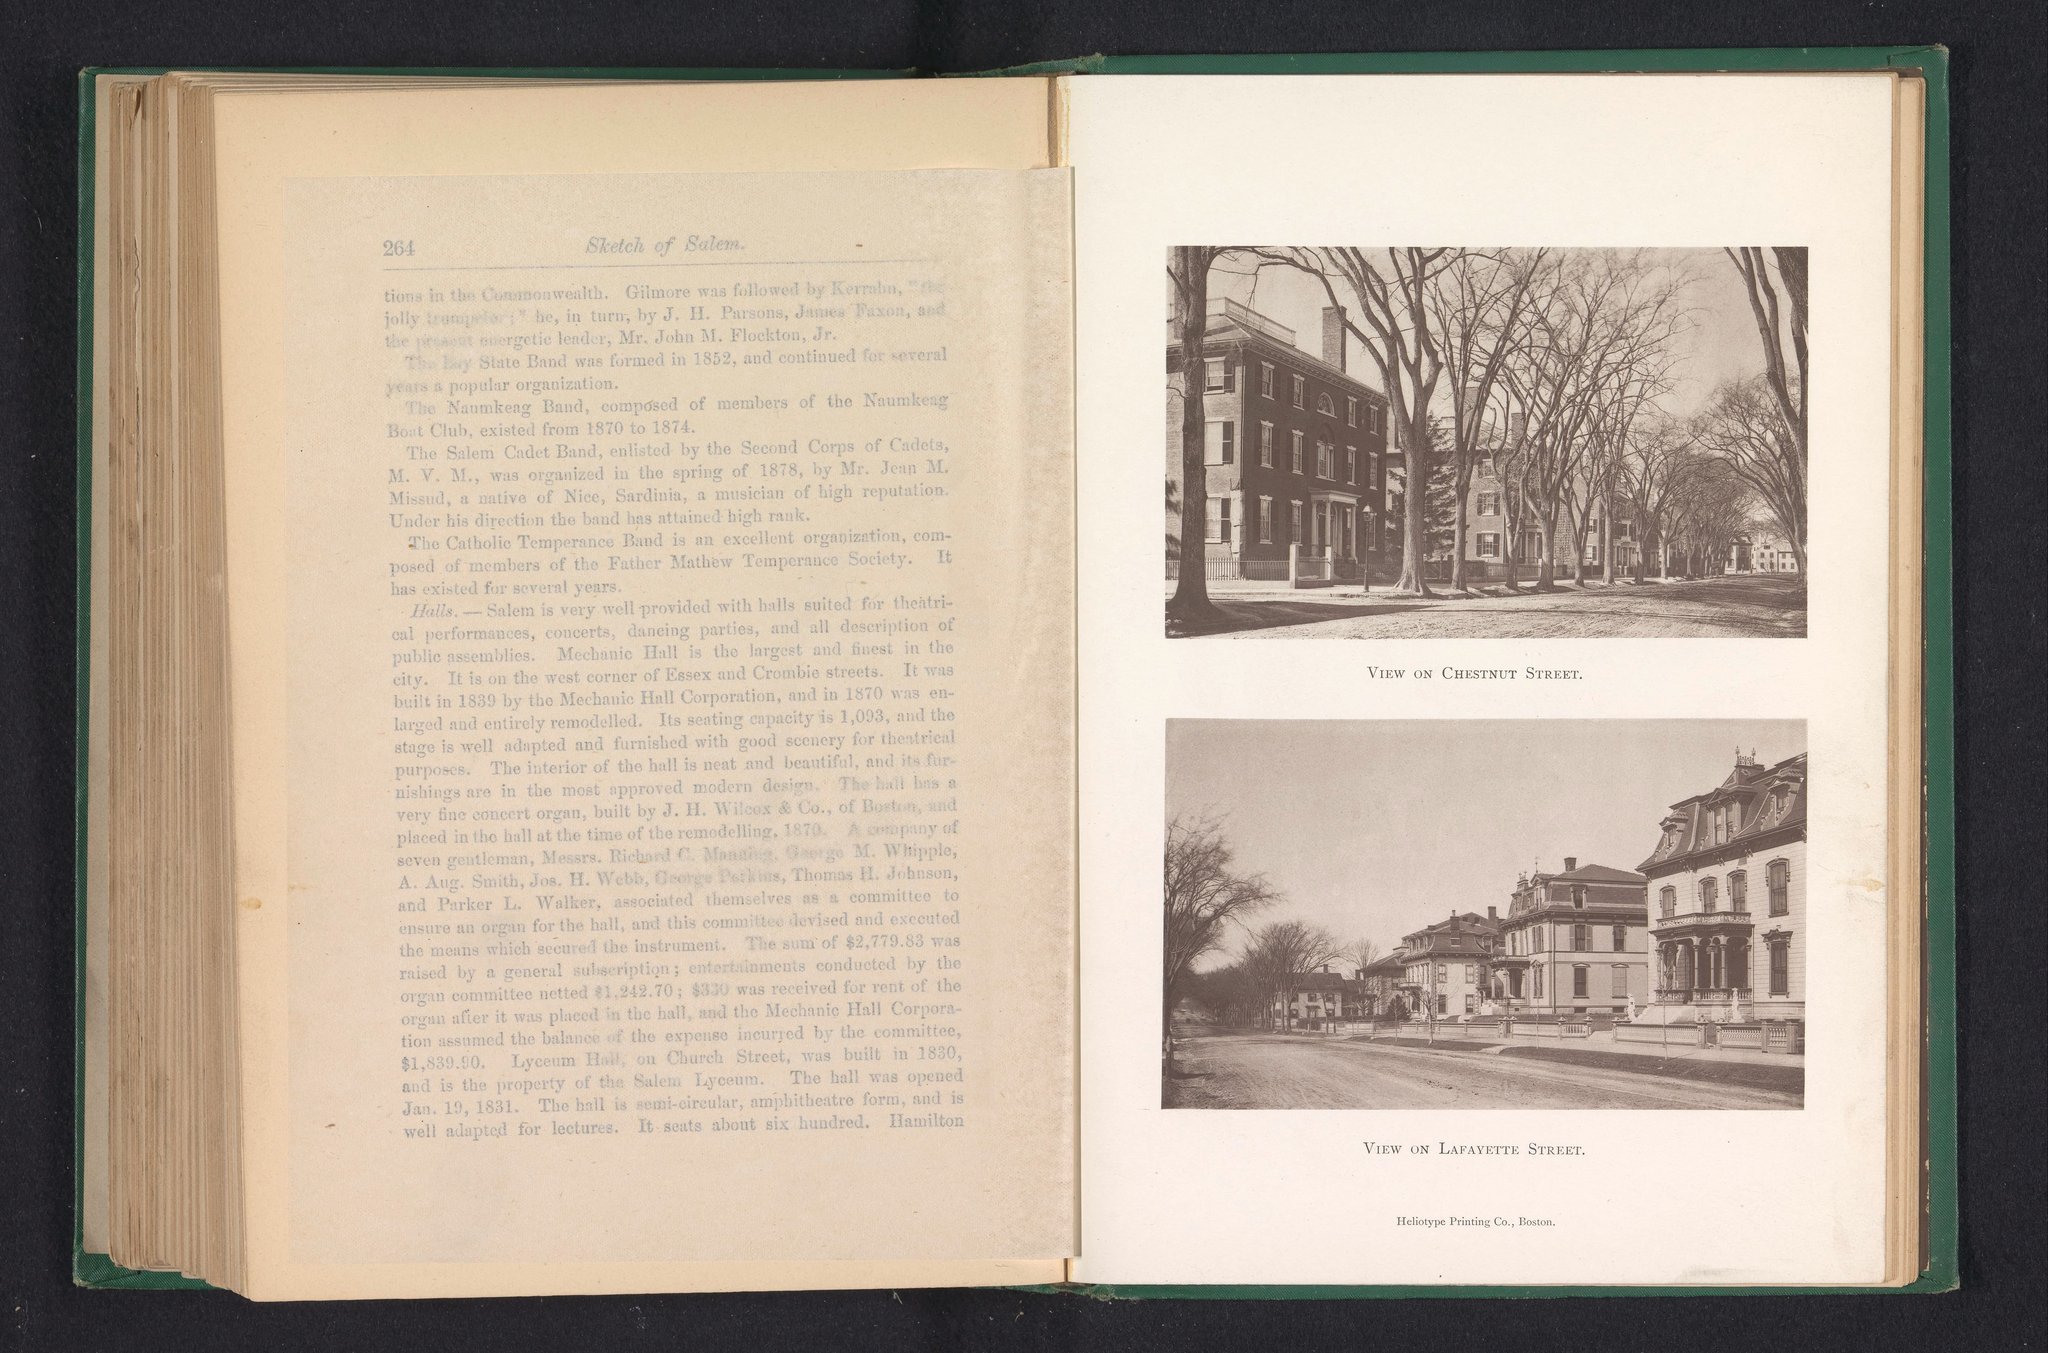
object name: photomechanical print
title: View on Chestnut Street. View on Lafayette Street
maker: Anonymous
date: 1804-1879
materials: paper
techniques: photoaquatint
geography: salem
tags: housing, street